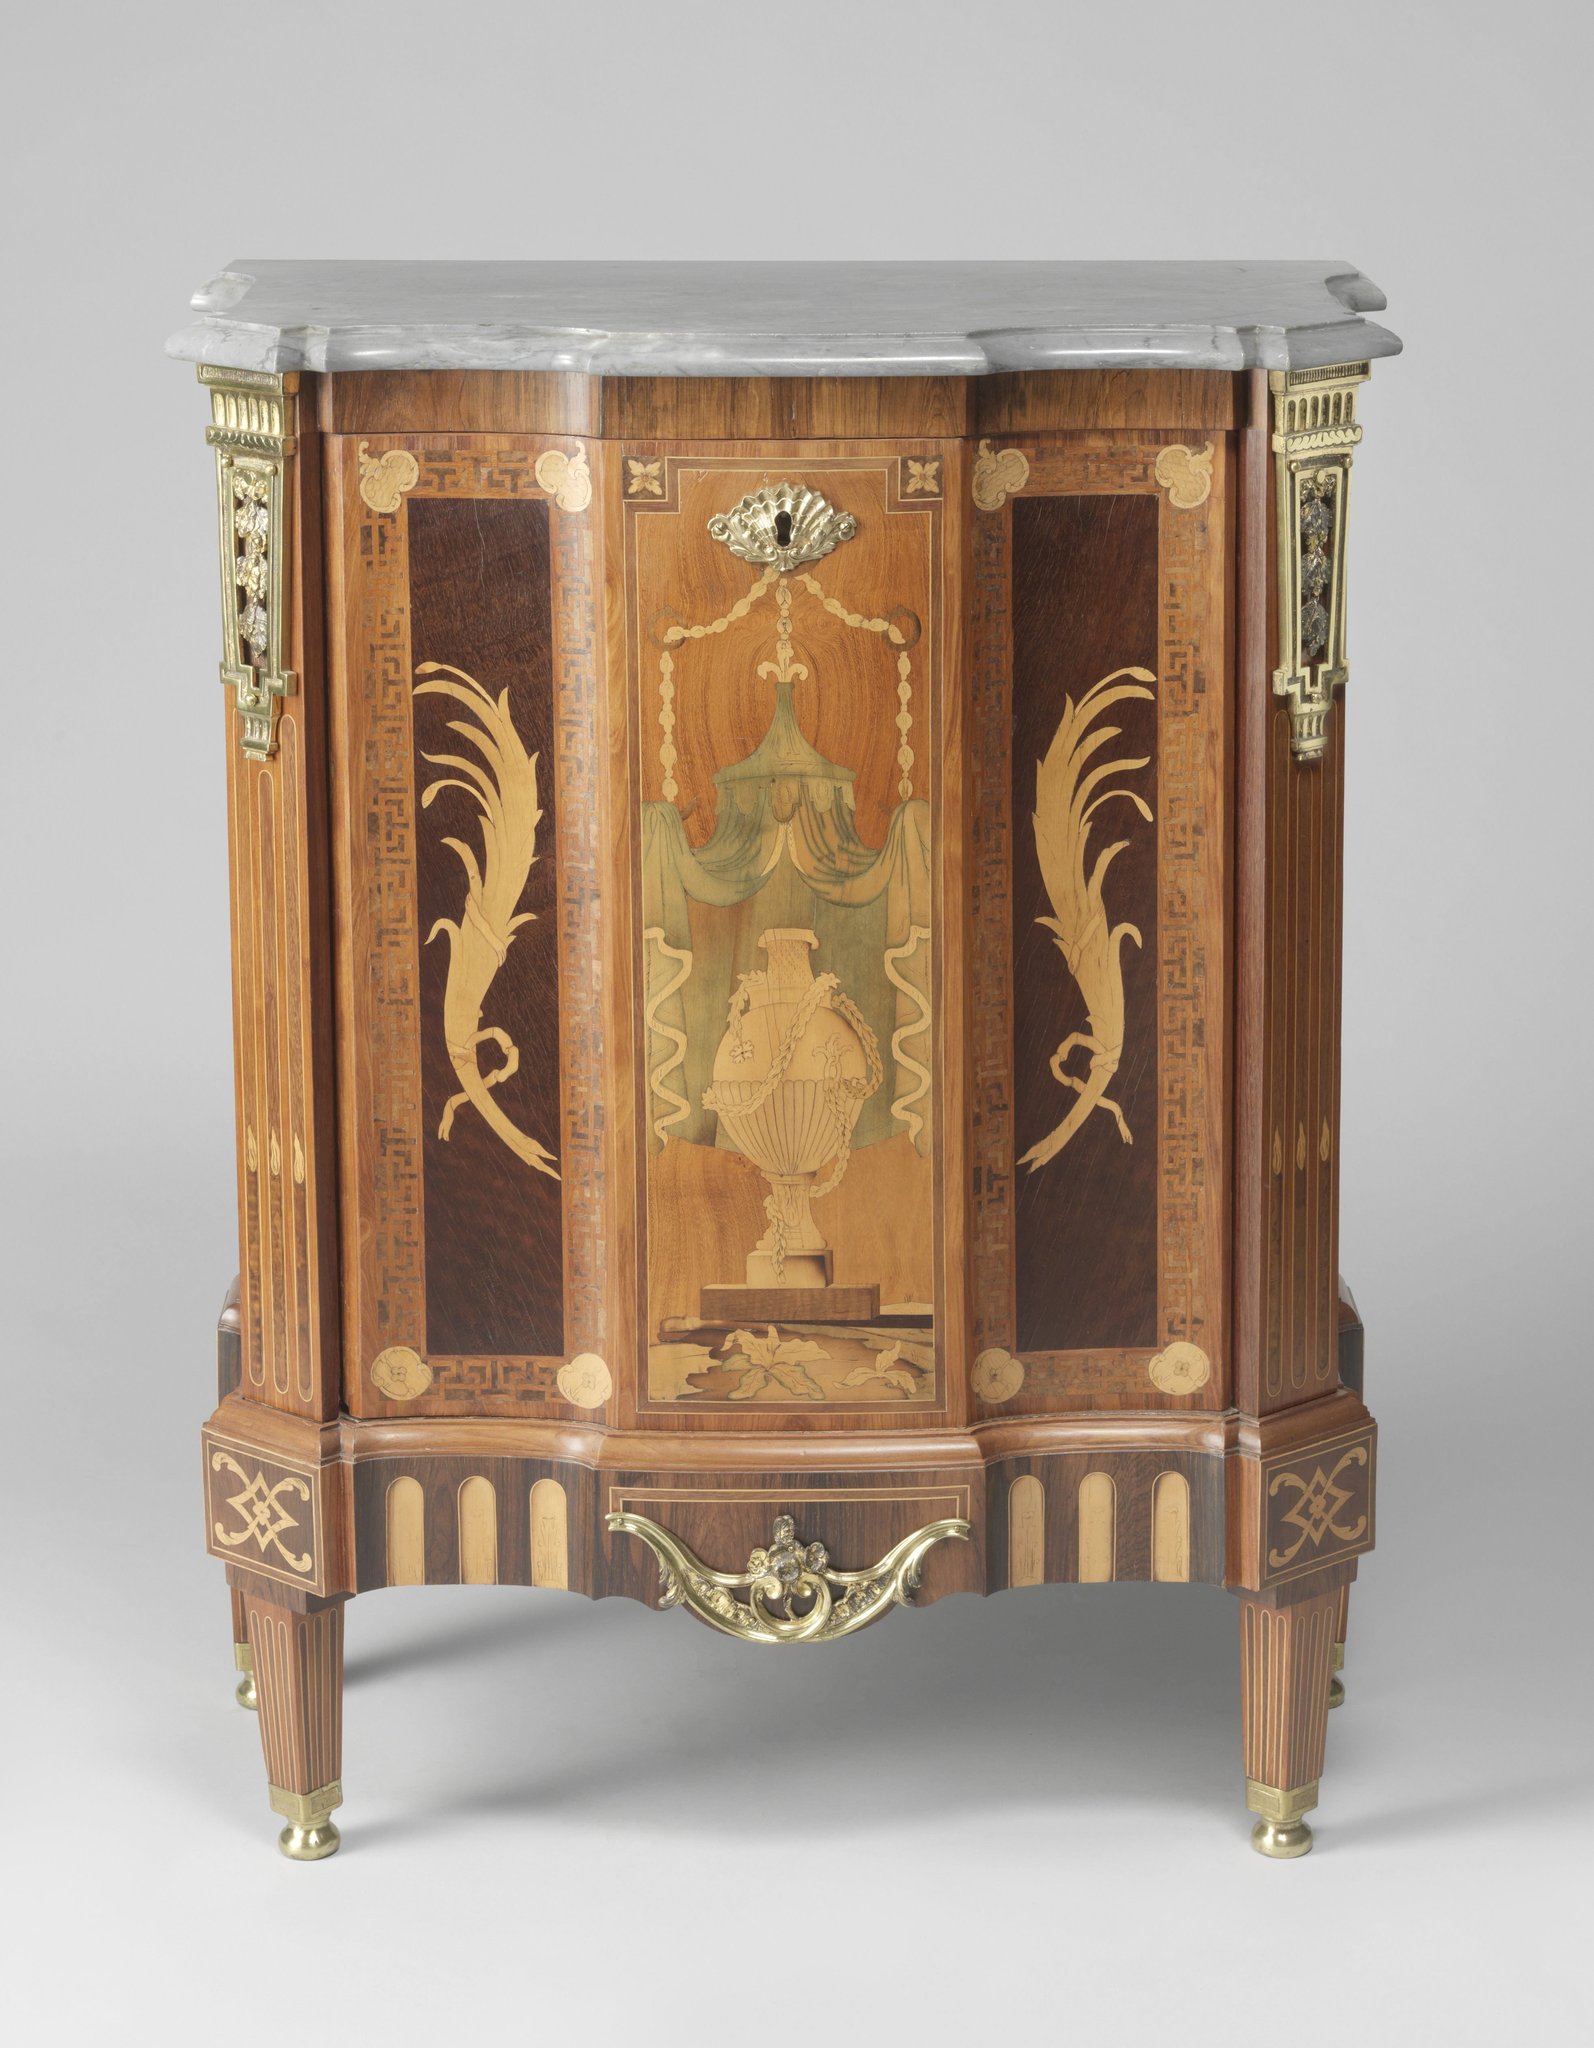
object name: case furniture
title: Commode and two cupboards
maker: Anonymous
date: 1770-1790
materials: copper, wood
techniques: gilding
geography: netherlands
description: These three pieces of furniture were made in the French style, which was emulated in all large Dutch cities in the third quarter of the 17th century. This is evident from their form, the marquetry ornamentation, the gilded mounts and the marble tops. The marquetry vases are taken from French prints and the mounts were probably cast from French examples. This ensemble is exceptionally elaborate by Dutch standards.